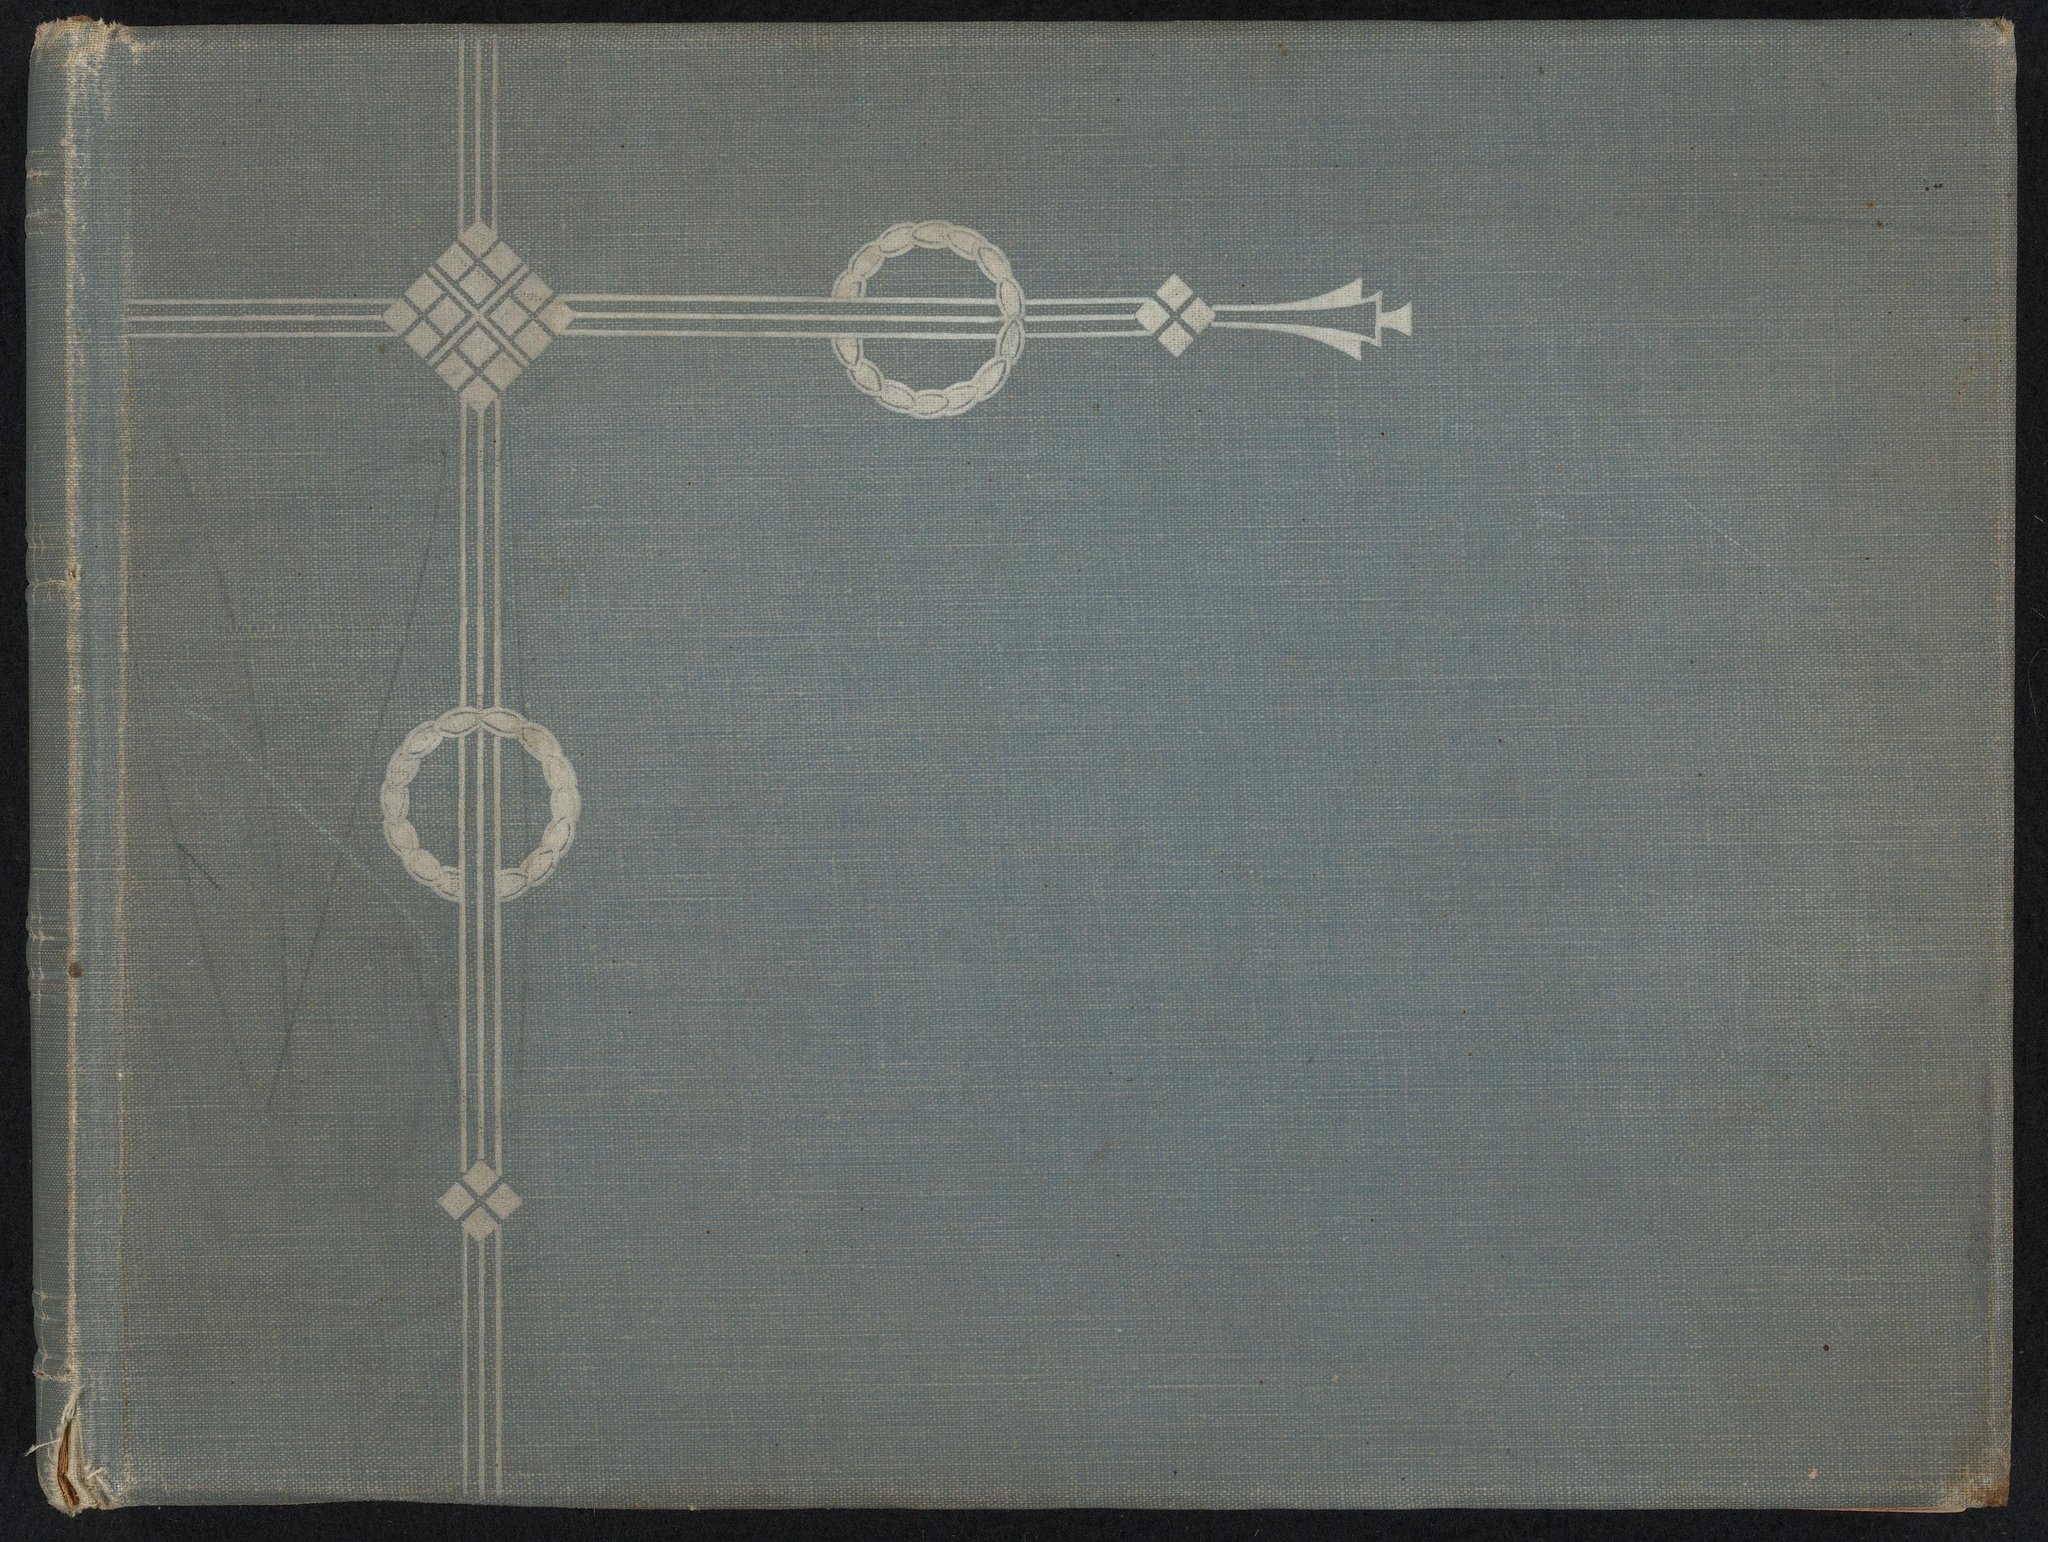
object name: photograph album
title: Fotoalbum van een Frans-Russische amateurfotografe in Rusland en Zwitserland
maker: Anonymous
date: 1910-1915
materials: paper, cardboard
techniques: collodion silver print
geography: europe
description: Plakboek met 89 foto's op 43 pagina's. Het album bevat foto's van een Frans-Russische amateurfotografe met foto's samen met vrienden en/of familie en zelfportretten, waaronder een serie zelfportretten voor de spiegel.